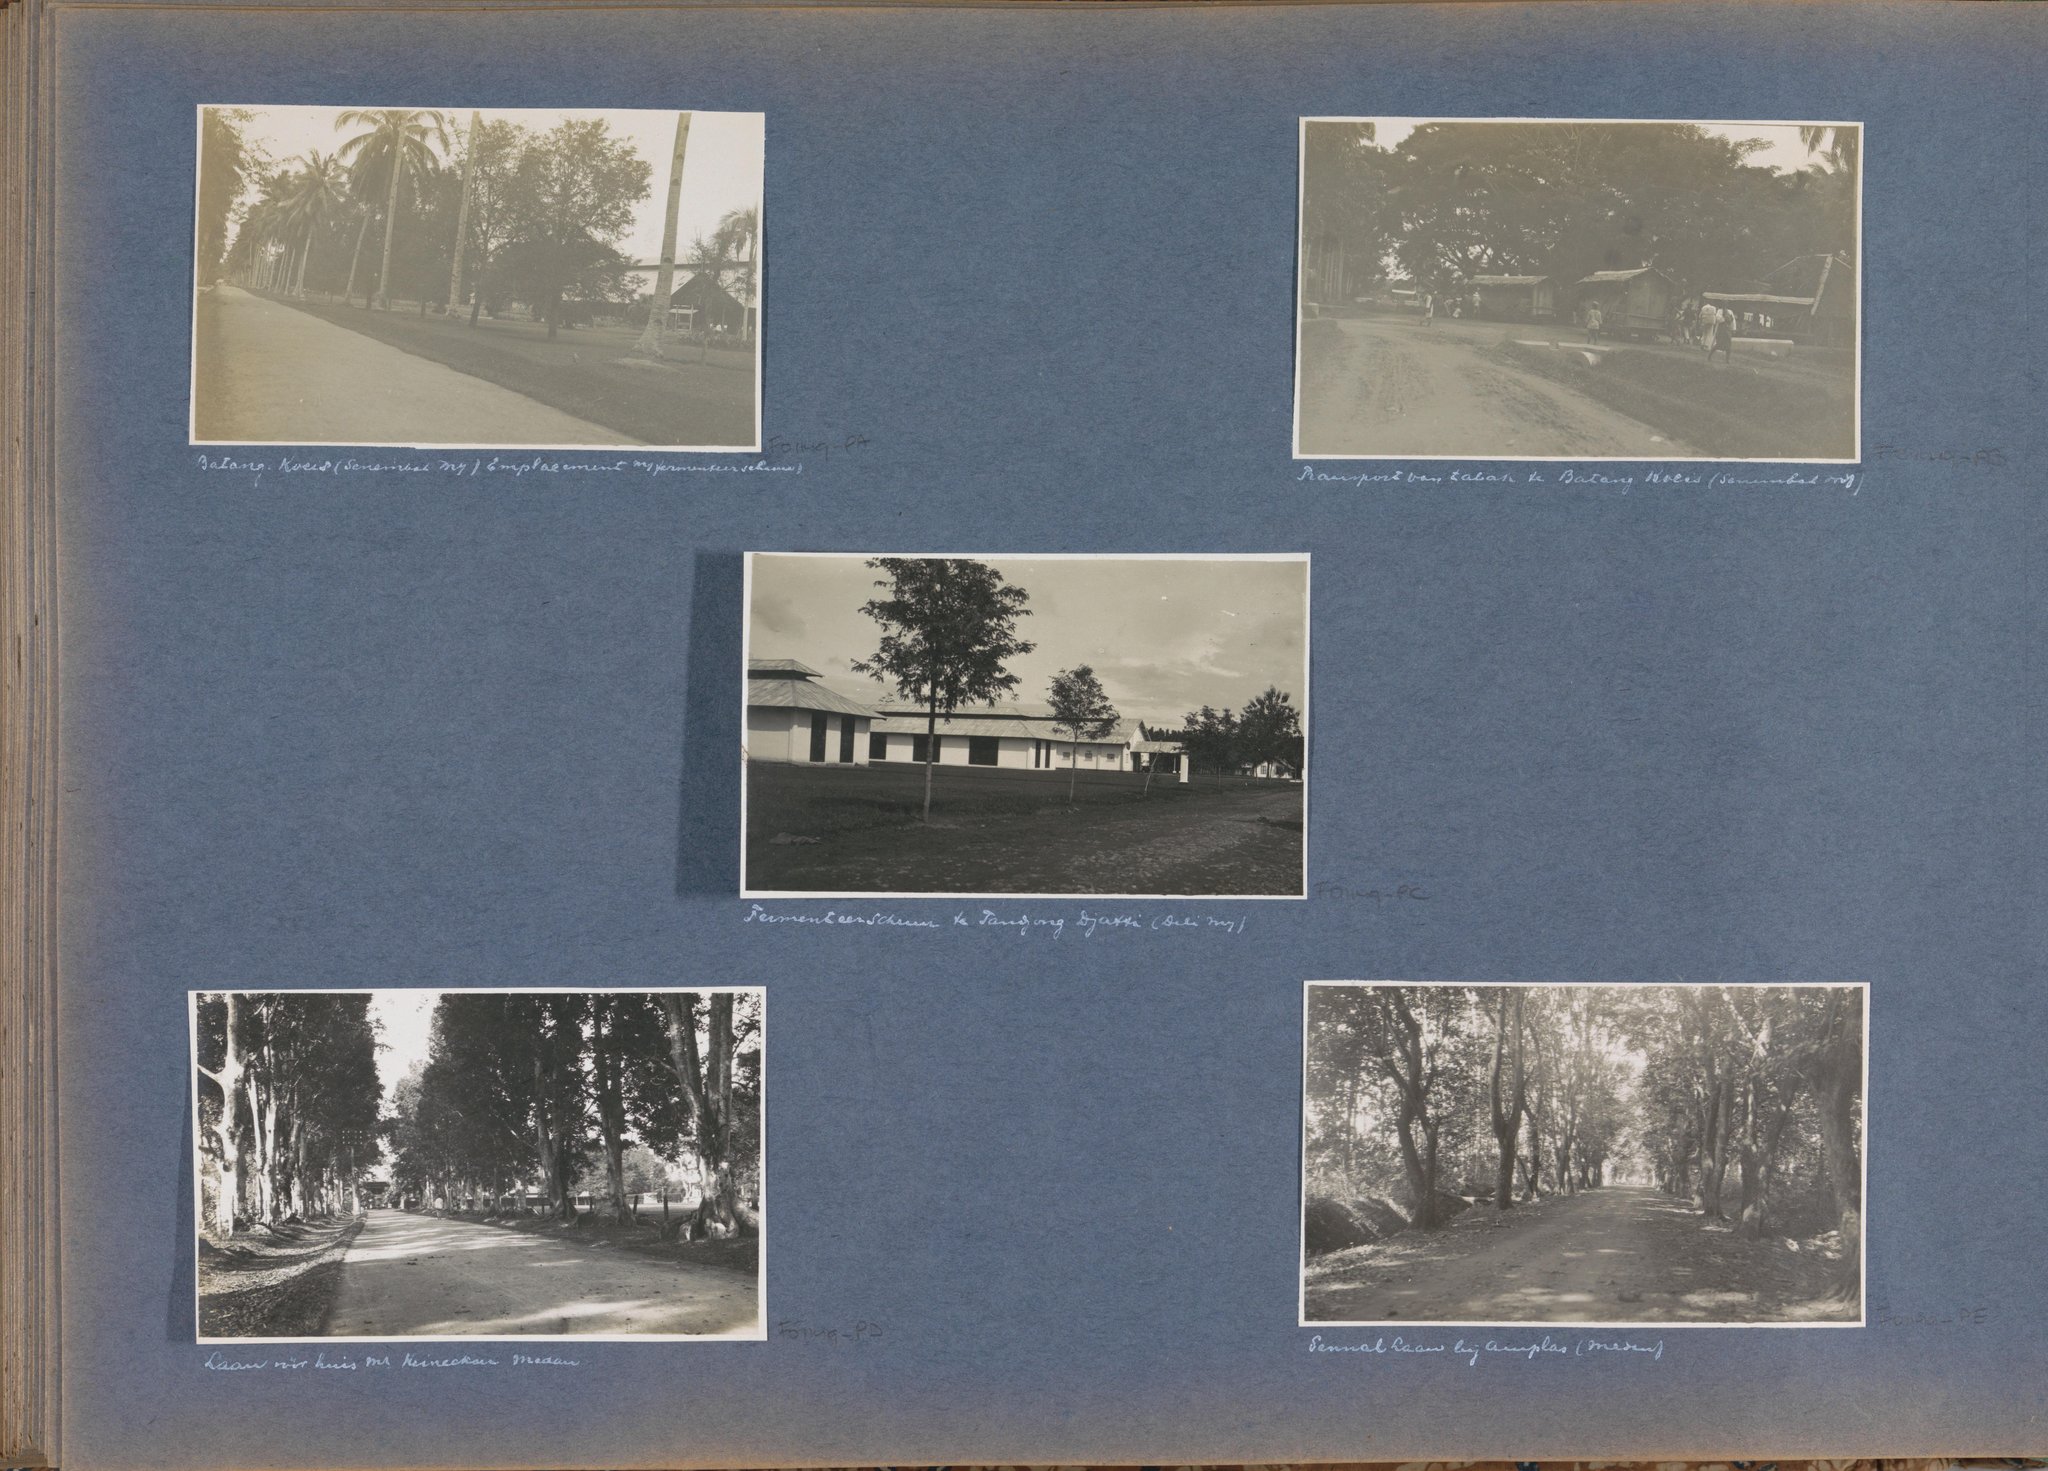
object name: photograph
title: Laan voor het huis van de heer Heinecken in Medan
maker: Anonymous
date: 1900-1920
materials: paper, photographic support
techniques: gelatin silver print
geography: medan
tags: forest path or lane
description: Onderdeel van reisalbum met foto's van bedrijvigheid en bezienswaardigheden op Sumatra en Java en van de reis naar en van Nederlands-Indië.